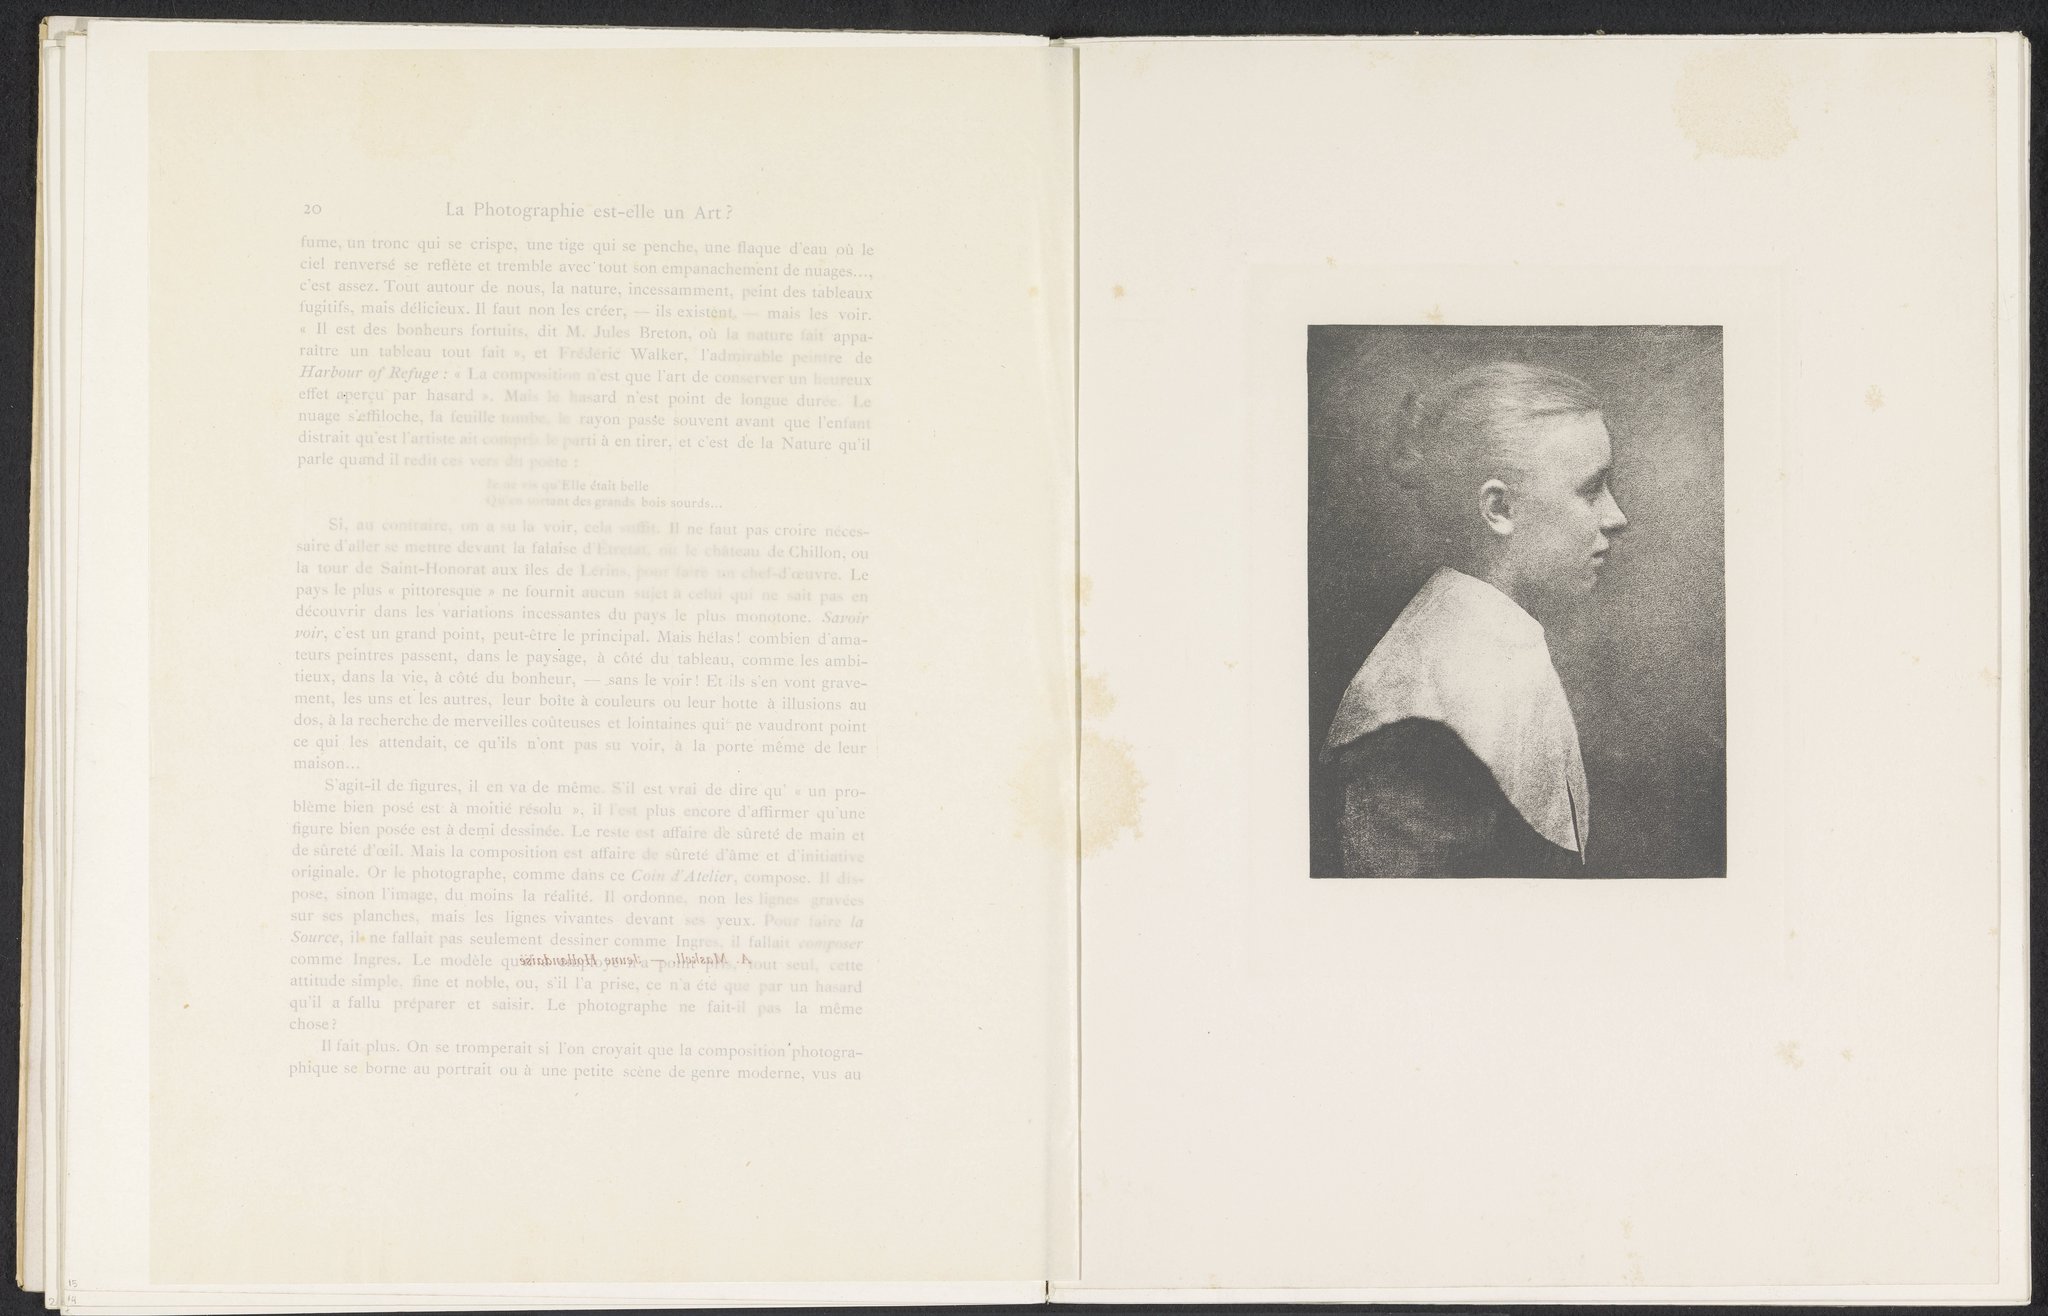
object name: page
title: Jeune Hollandaise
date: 1896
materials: paper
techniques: photoaquatint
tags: folk costume, regional costume